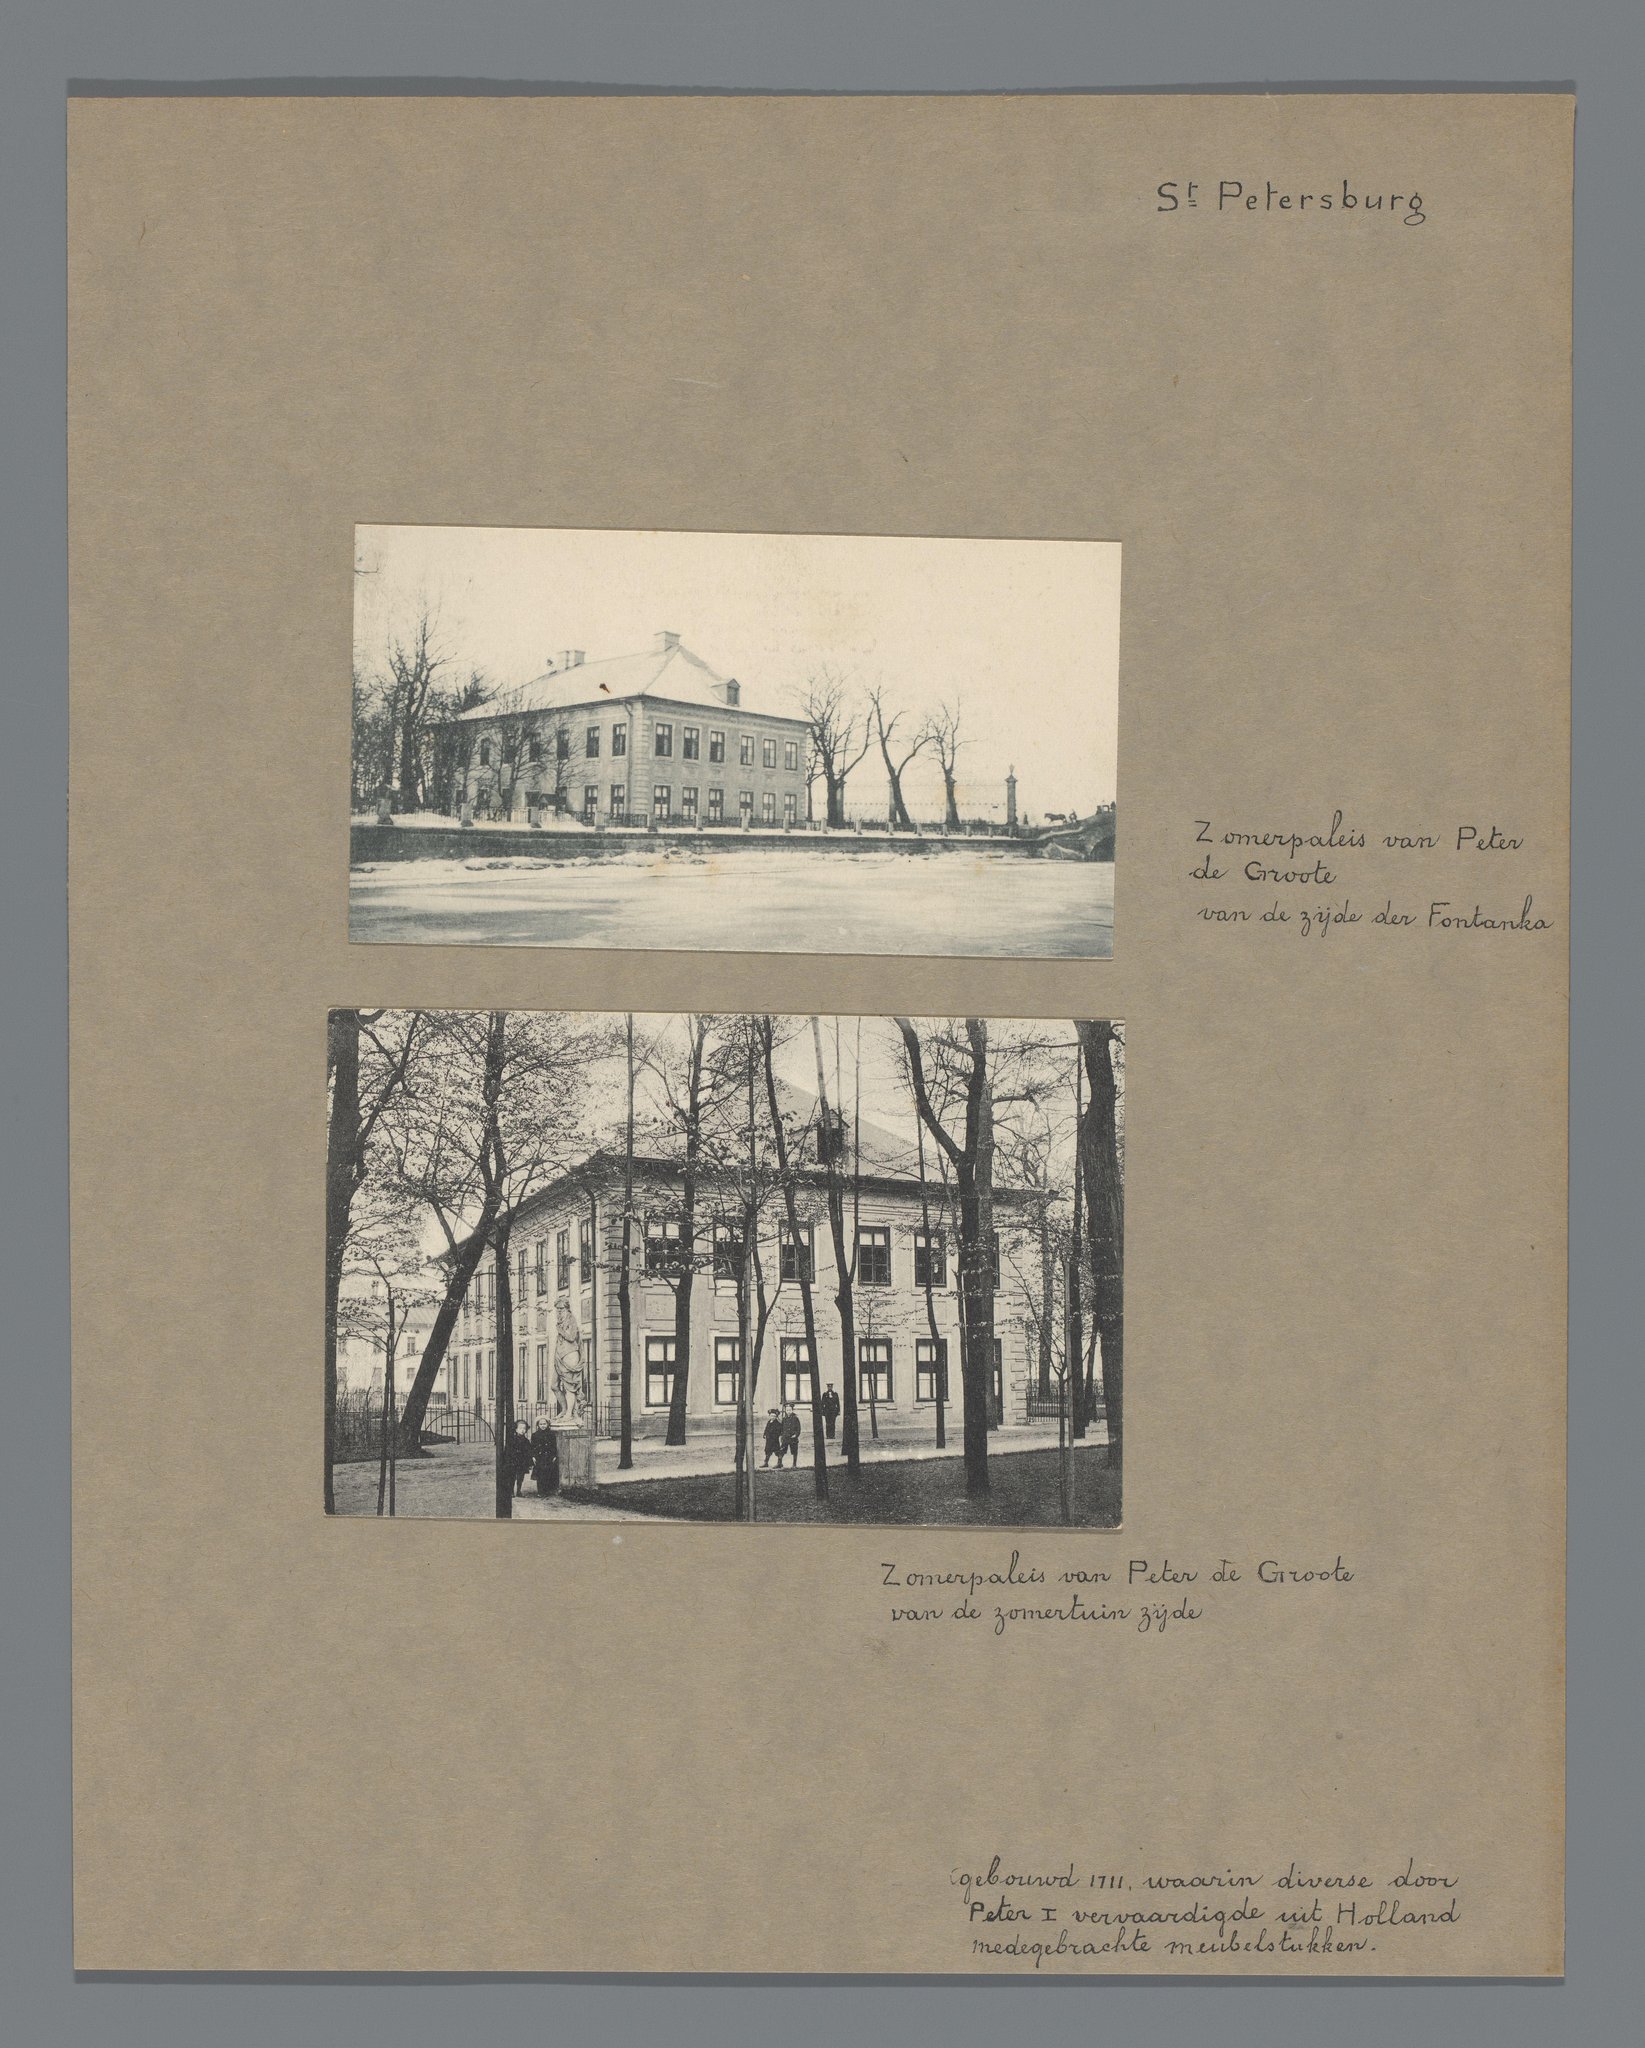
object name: photograph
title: St. Petersburg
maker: Anonymous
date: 1860-1925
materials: photographic support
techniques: photograph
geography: russia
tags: sint-petersburg